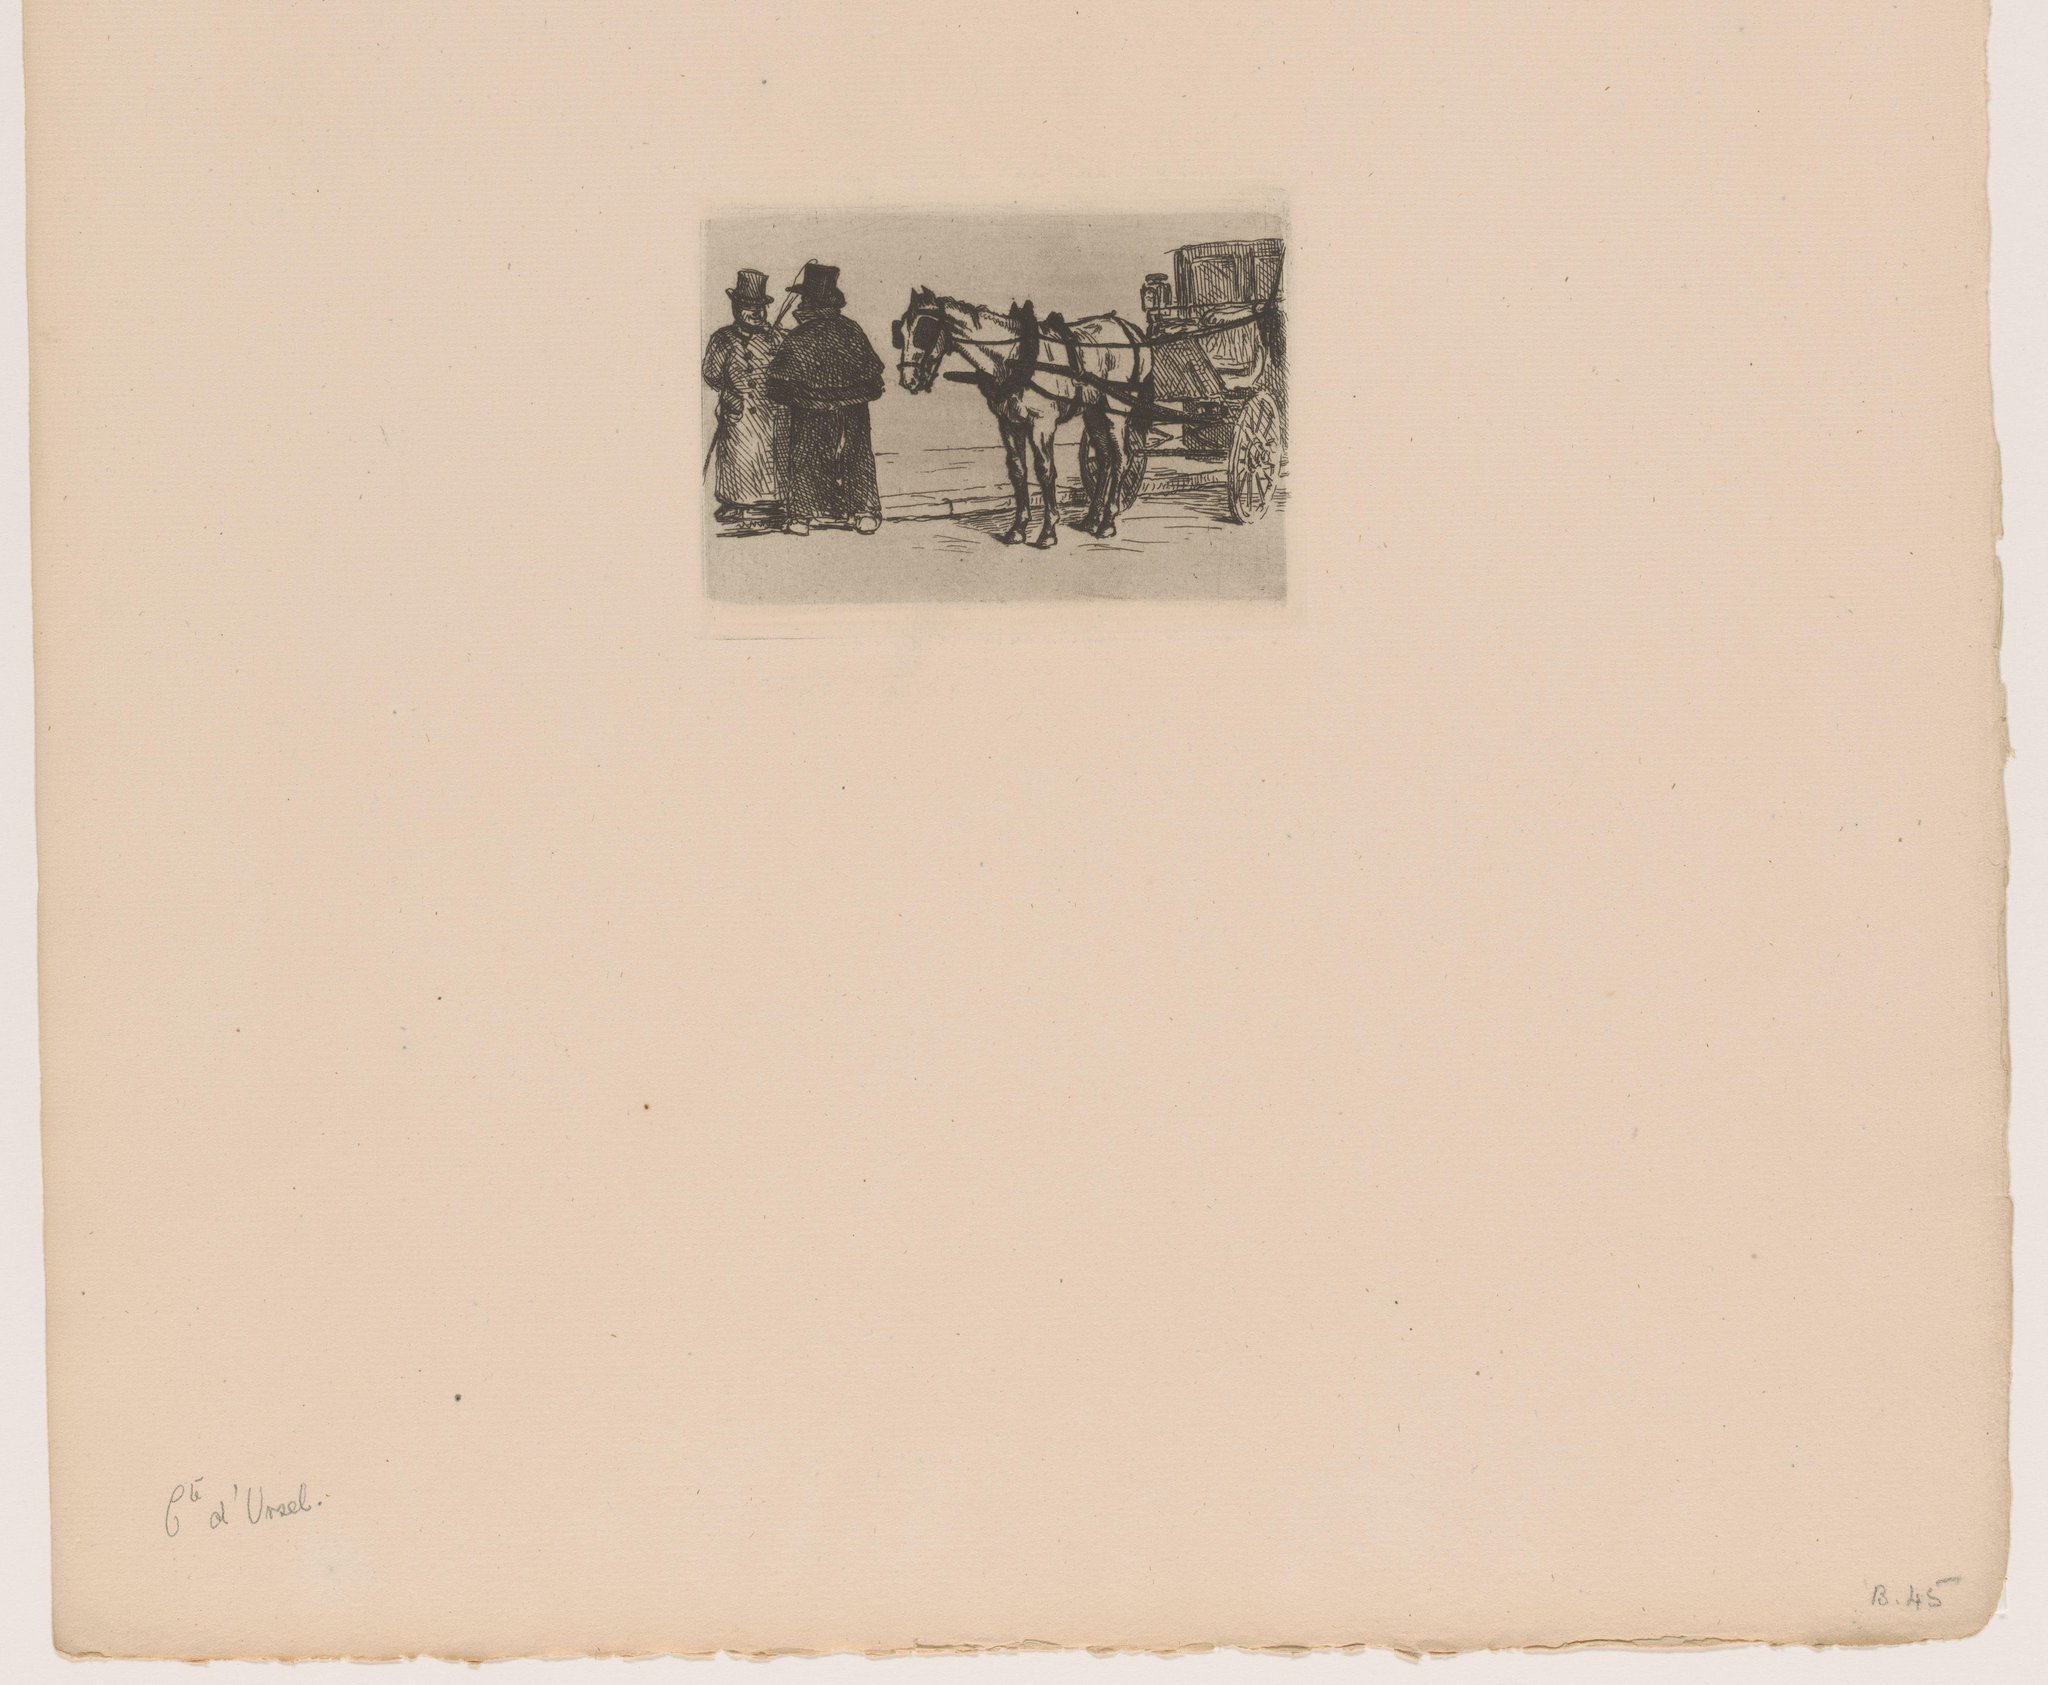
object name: print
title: Twee koetsiers bij een rijtuig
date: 1875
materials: paper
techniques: etching, intaglio, retroussage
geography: brussels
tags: four-wheeled vehicle drawn by one animal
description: Prent uit: Rops, Félicien (red.), Cahier d'études eaux-fortes originales et inédites. Brussel: Felix Callewaert père, 1875.